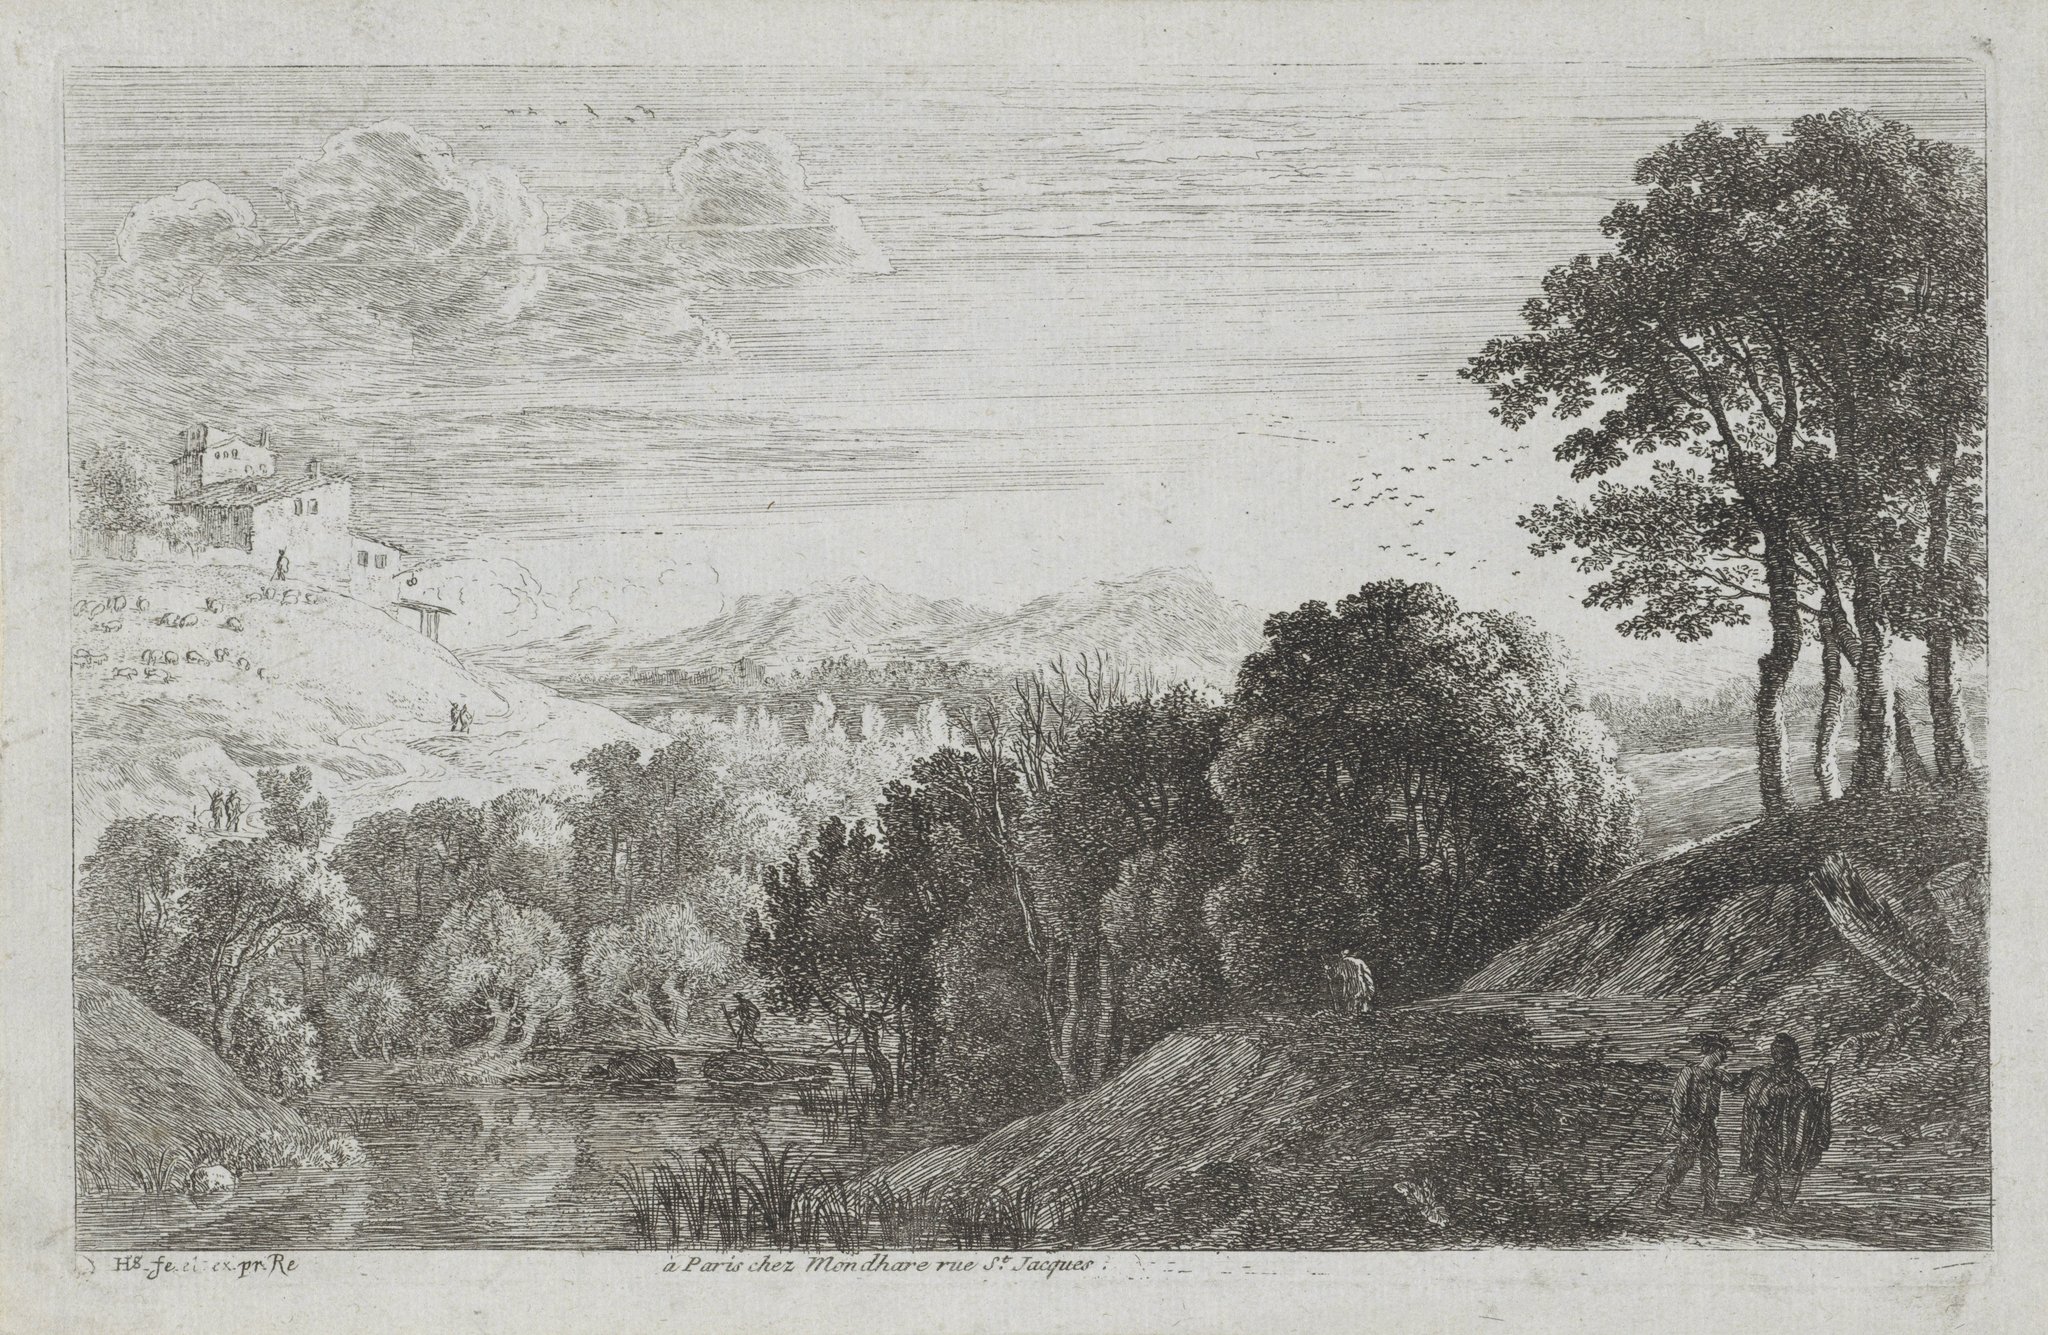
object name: print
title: Landschap met zonsondergang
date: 1759-1784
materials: paper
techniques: etching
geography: paris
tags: river, herding, herdsman, herdswoman, shepherd, shepherdess, cowherd, etc., rural housing, e.g. country-house, villa, cottage, (high) hill, sheep, sunset, 'en route', traveller under way, mountains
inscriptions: collector's mark: Lugt 2228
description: Op een pad langs de rivier lopen enkele wandelaars. Een wandelaar steekt de rivier over en in de verte ligt een gebouw op een heuvel. Bij het gebouw hoedt een herder een kudde schapen.